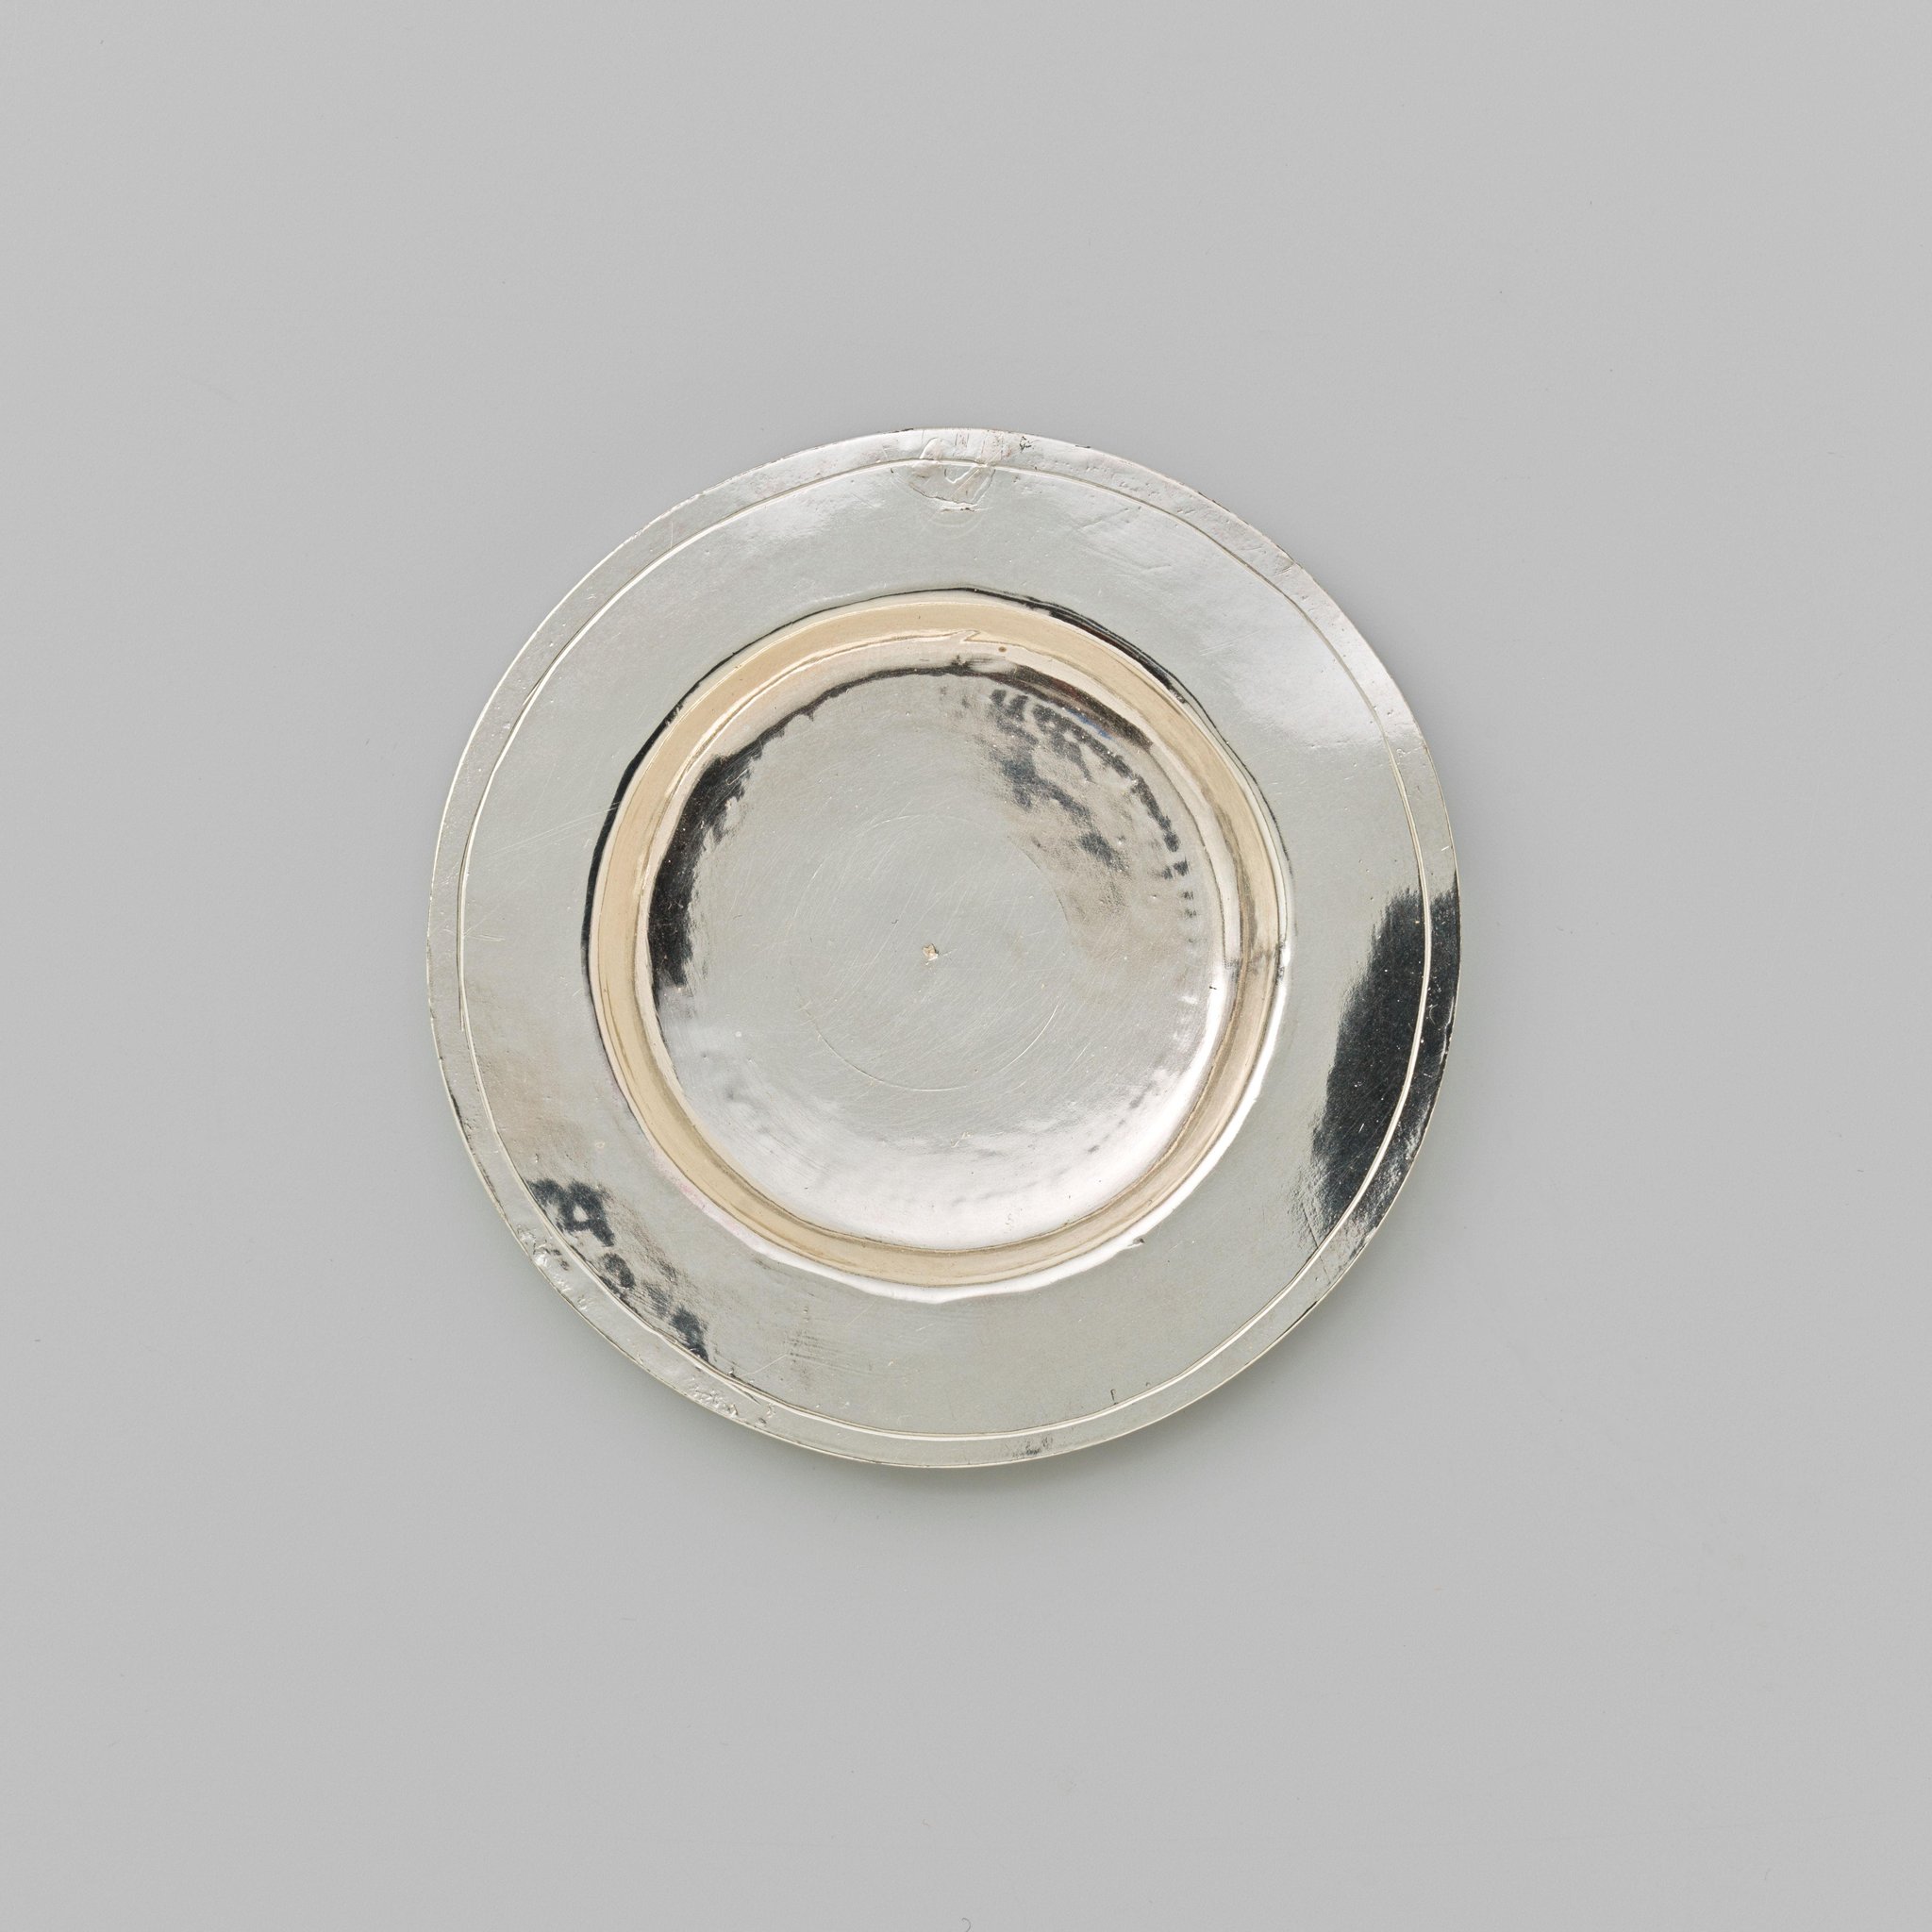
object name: platter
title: Schotel van zilver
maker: wessel jansen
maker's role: silversmith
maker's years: -1696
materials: silver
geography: amsterdam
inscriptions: maker's mark: ‘W (Citroen 1975, nr. 903)’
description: Schotel van zilver, rond, met brede gladde rand met groefversiering. Op de schotel staat de plaats van een lampetkan door middel van een cirkel aangegeven.